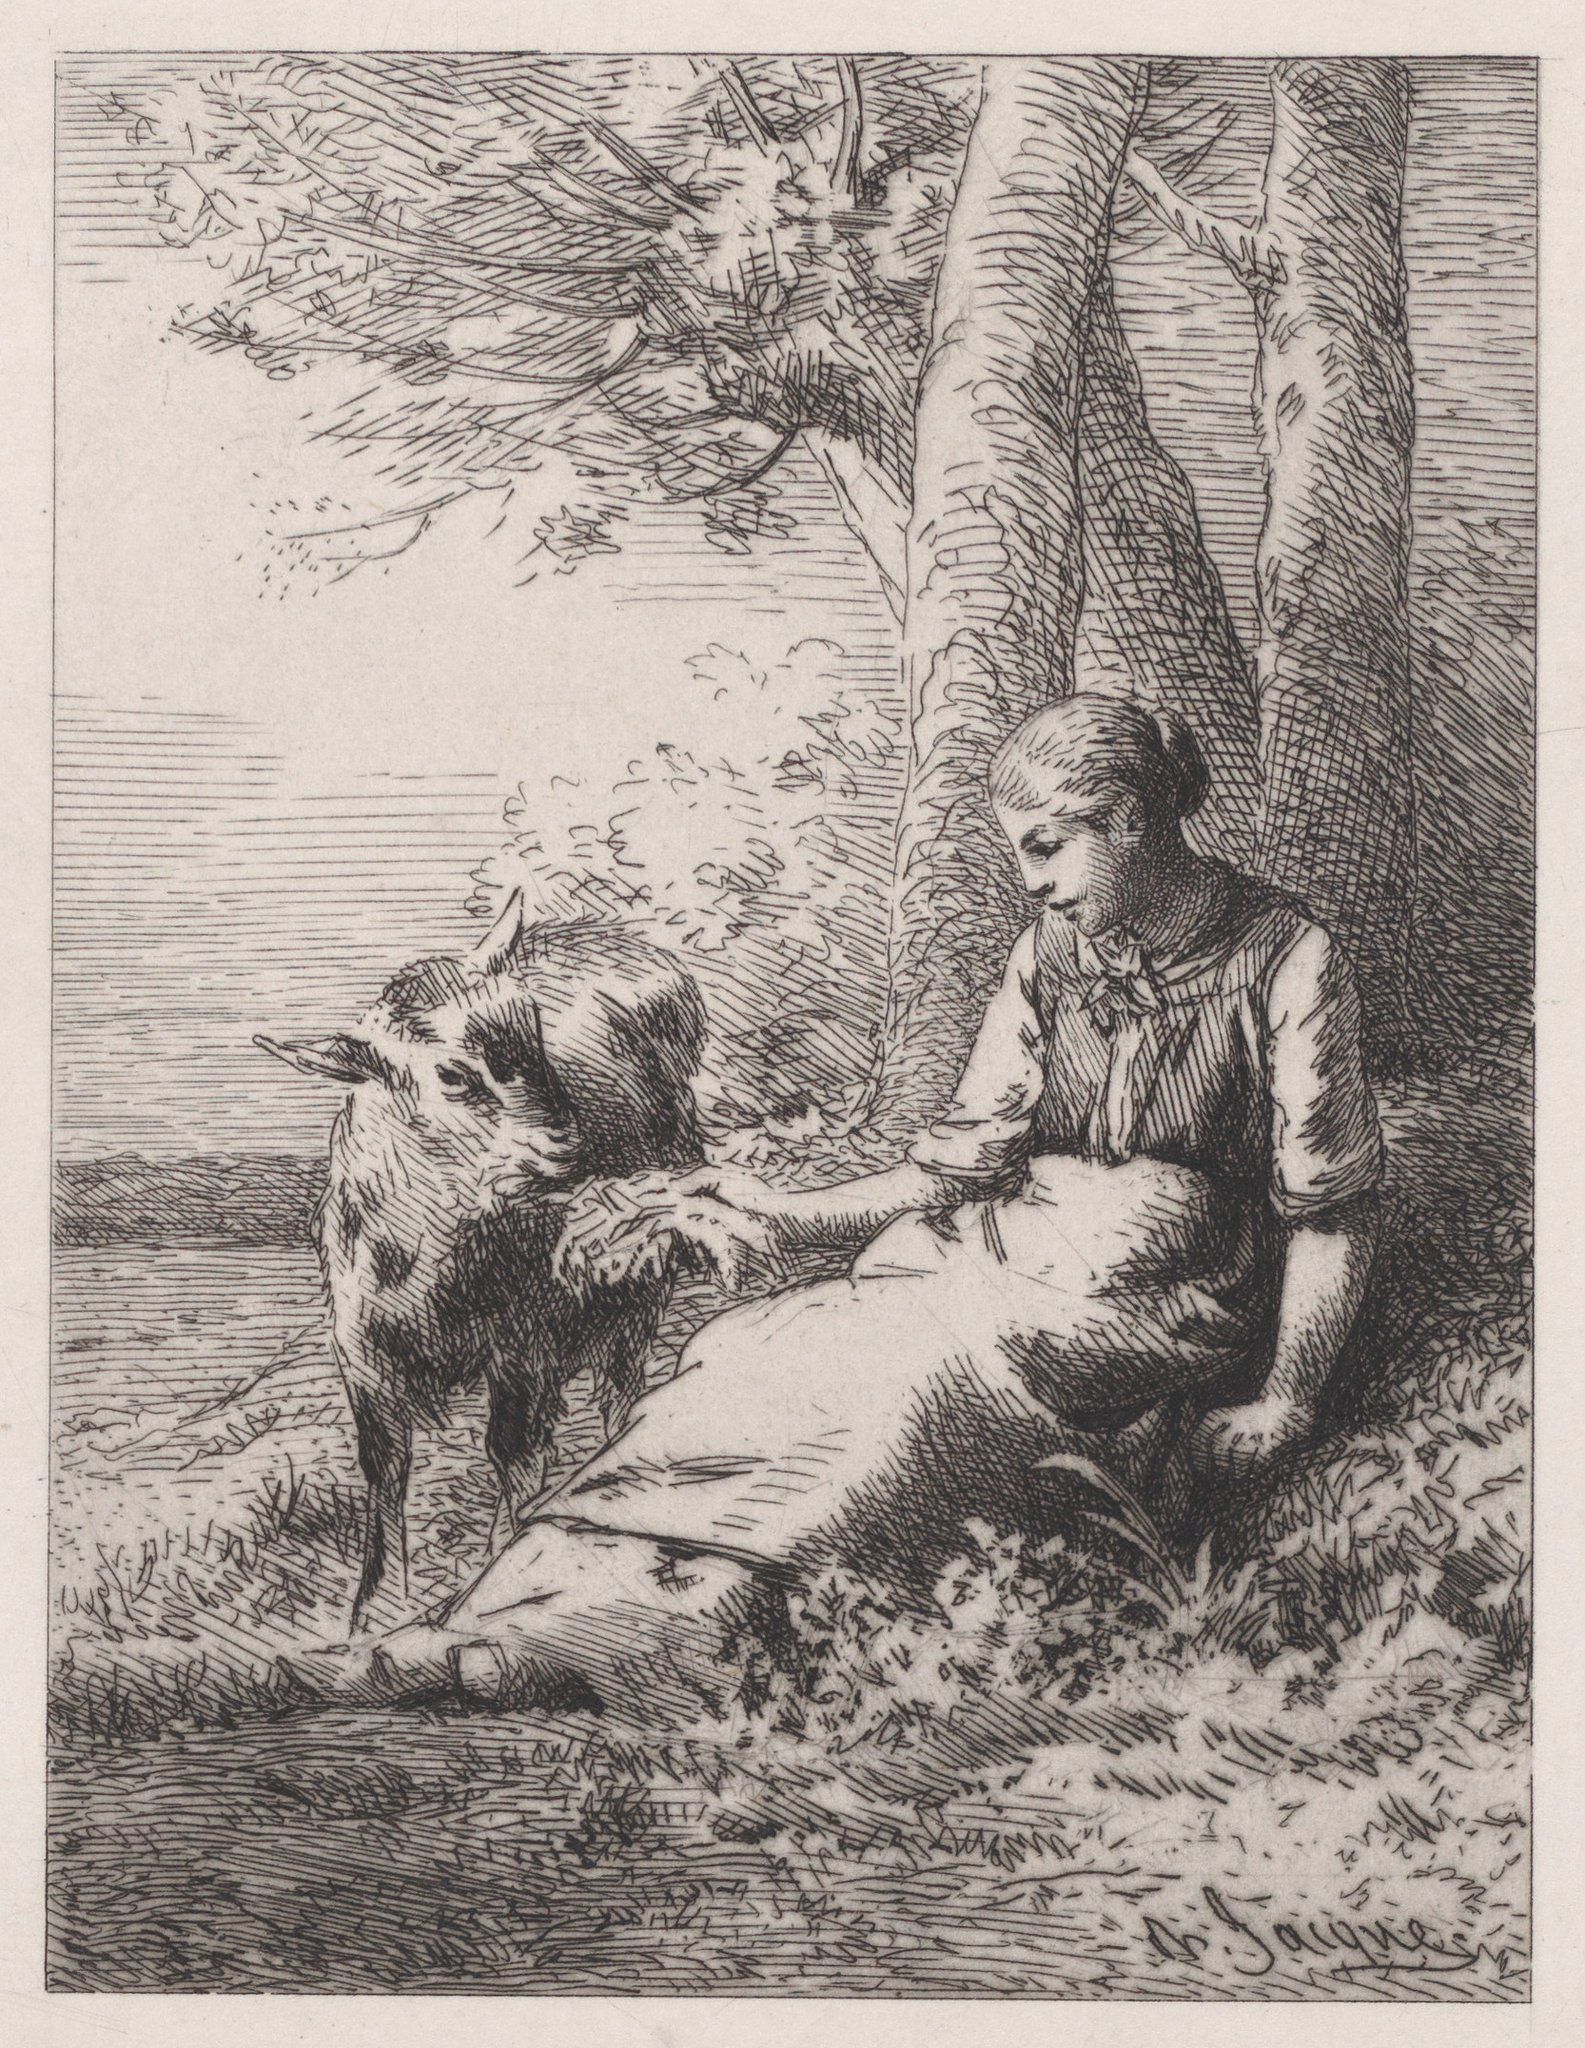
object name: print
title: Une Amitié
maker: charles émile jacque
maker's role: artist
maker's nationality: french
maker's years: 1813-1894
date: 1867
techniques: drypoint, etching